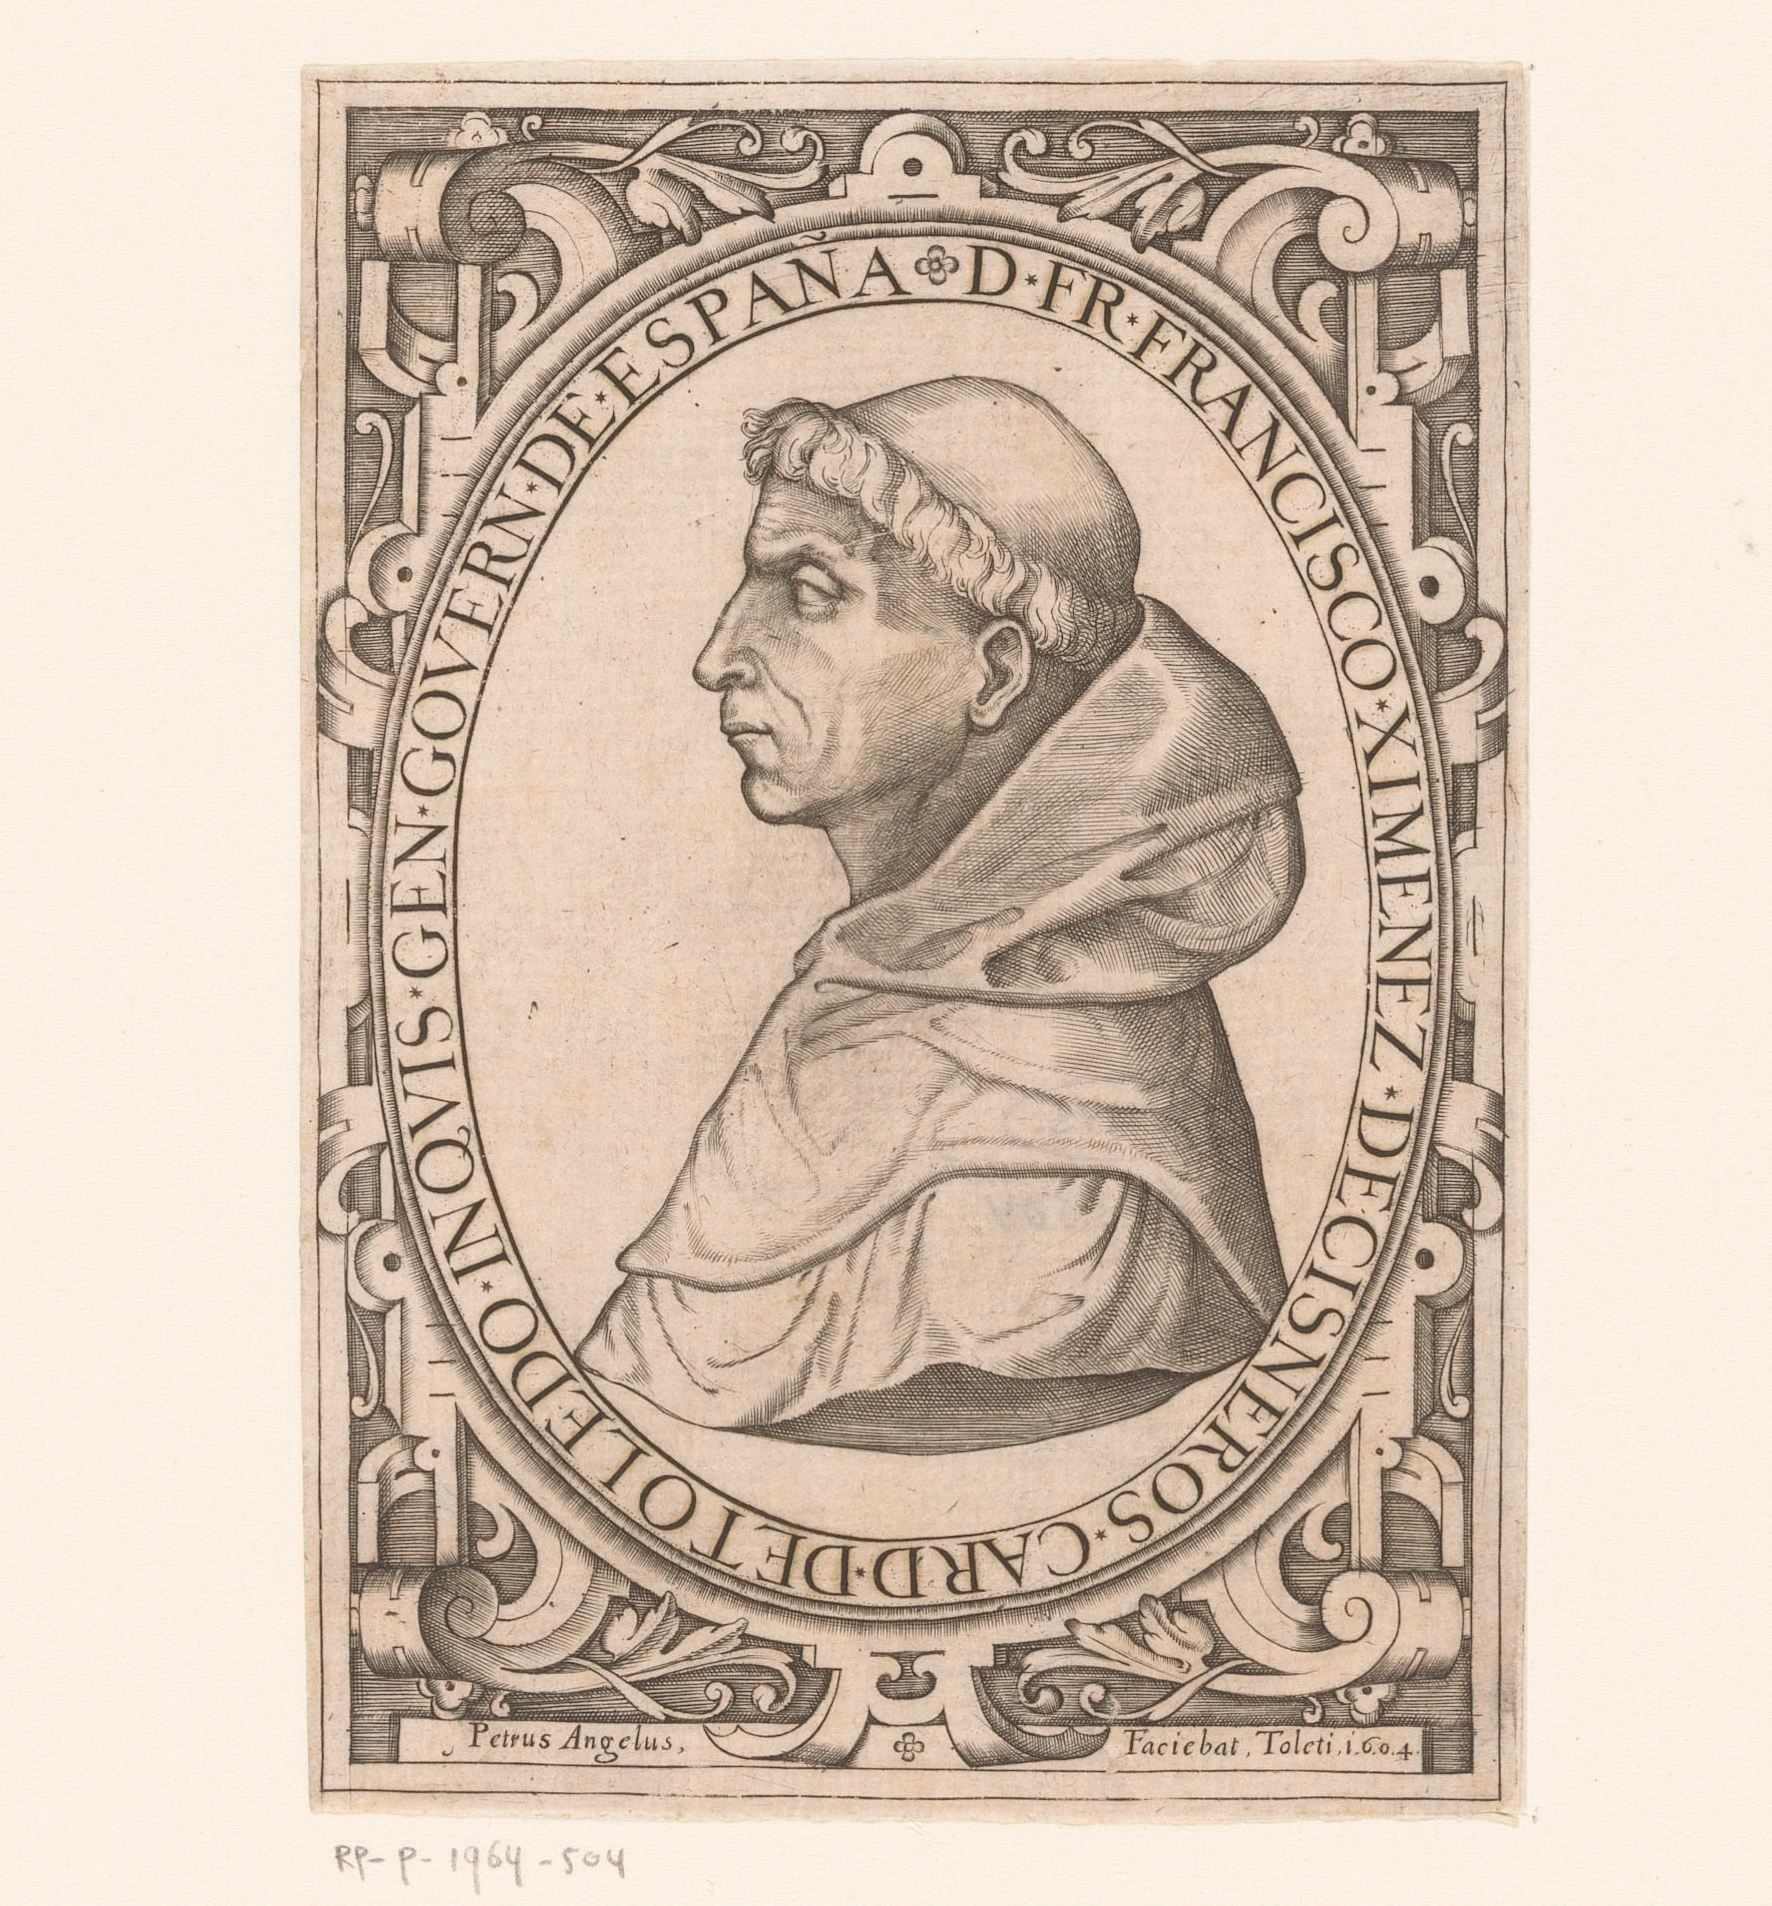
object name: print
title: Portret van kardinaal Francisco Jiménez de Cisneros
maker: pedro angel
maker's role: print maker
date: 1604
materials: paper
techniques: etching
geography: toledo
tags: cardinal, historical persons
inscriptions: collector's mark: Lugt 2228